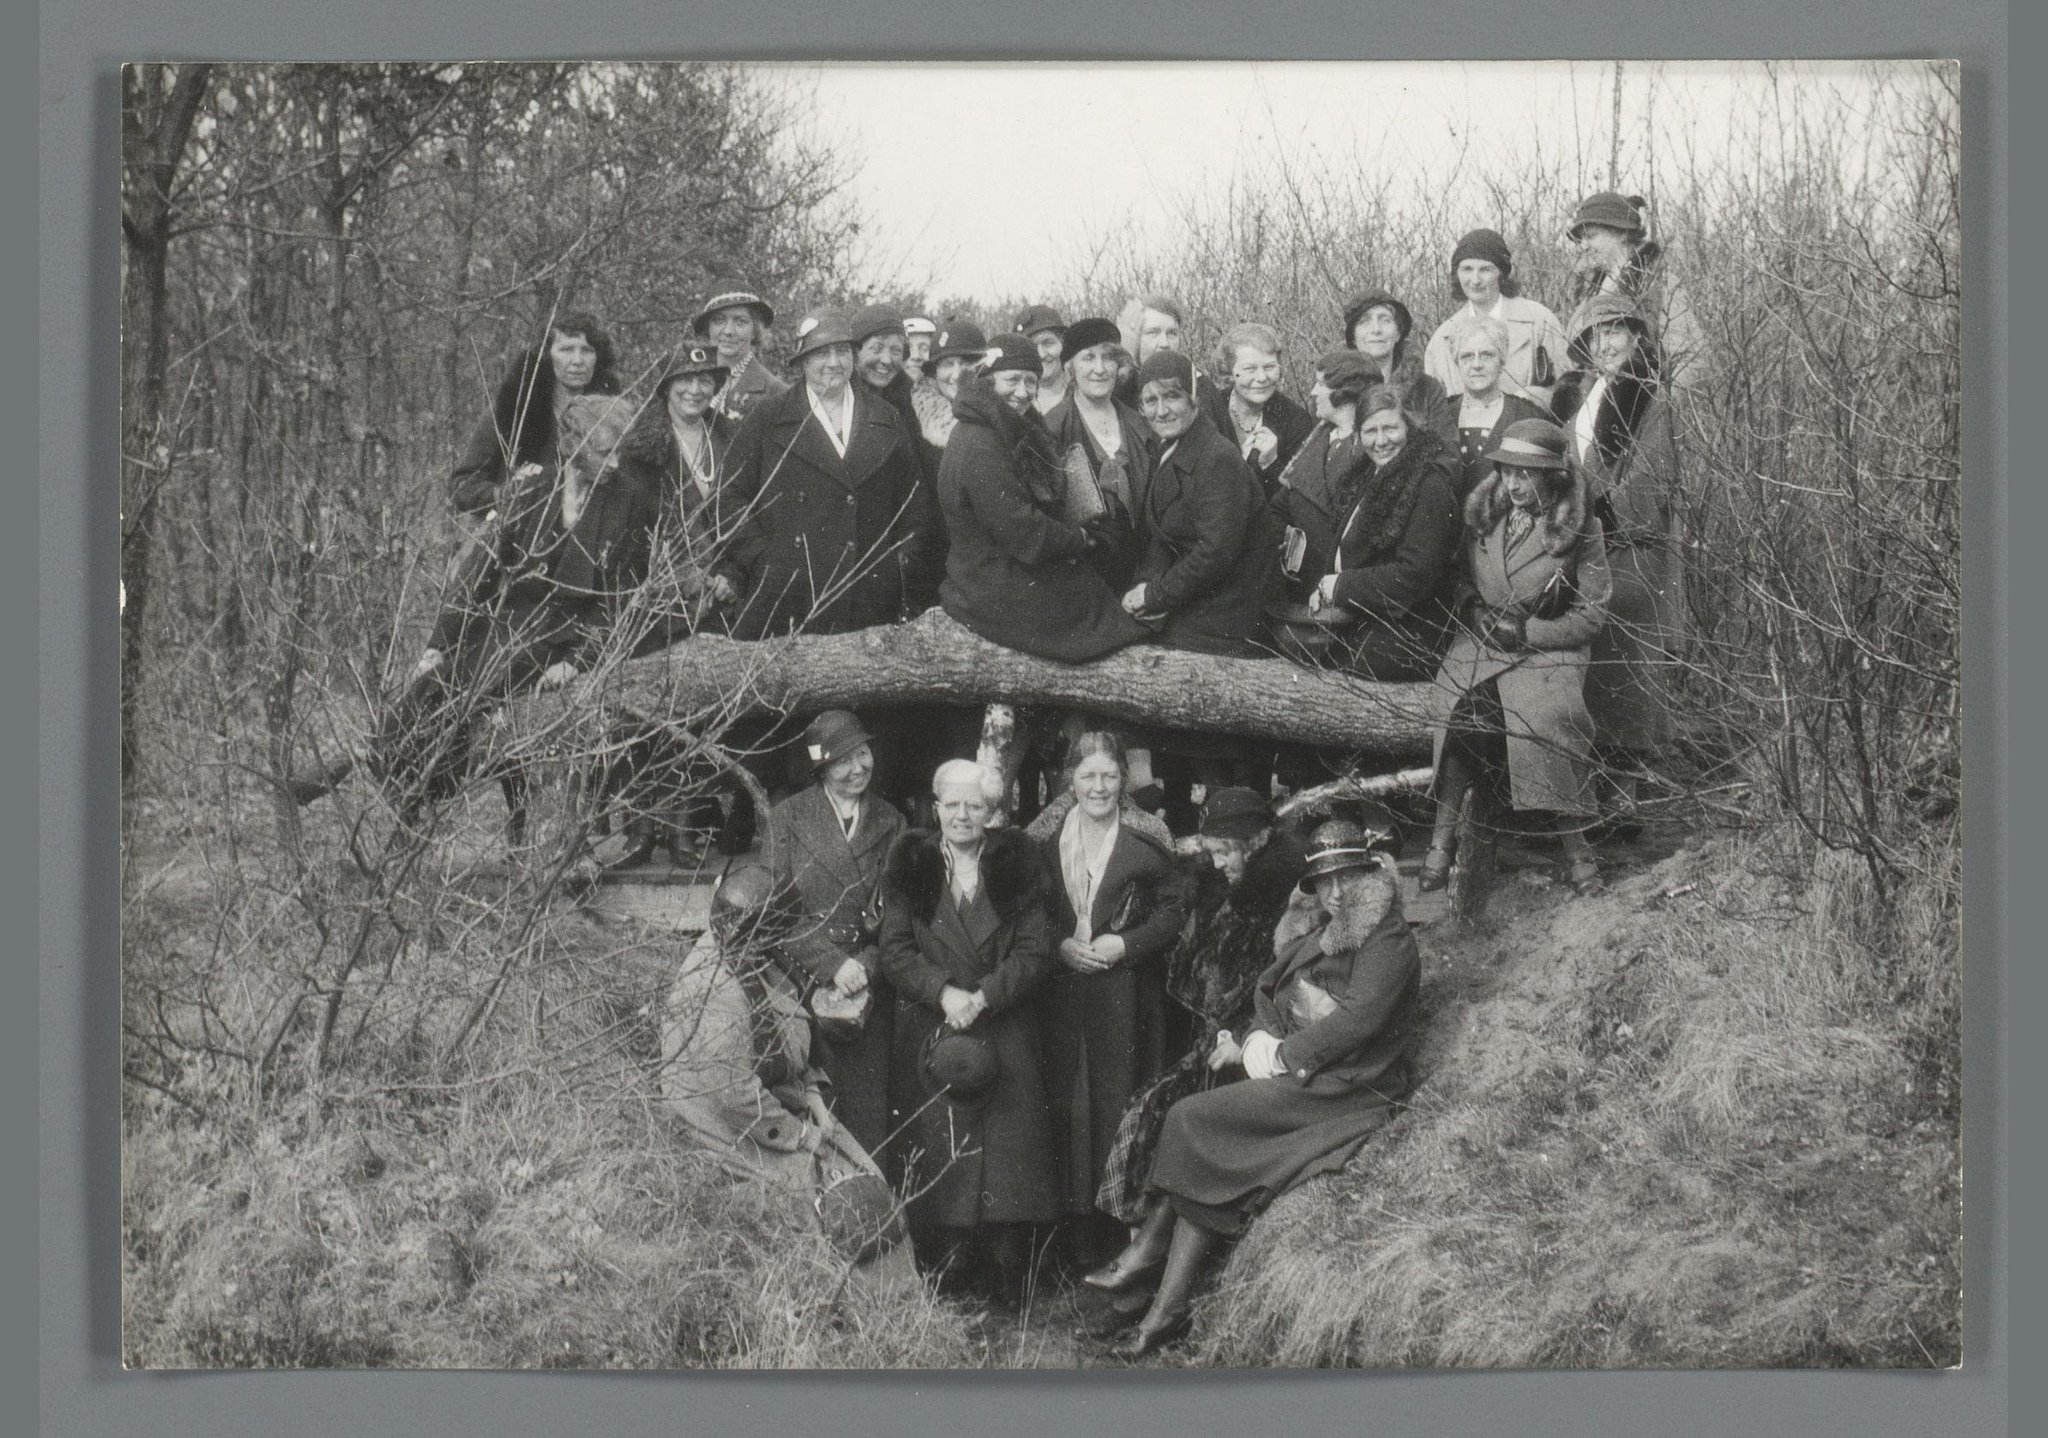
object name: photograph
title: Groepsportret van onbekende vrouwen rond een boomstronk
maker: Anonymous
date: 1920-1950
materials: paper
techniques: gelatin silver print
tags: anonymous historical persons portrayed in a group, in a group-portrait